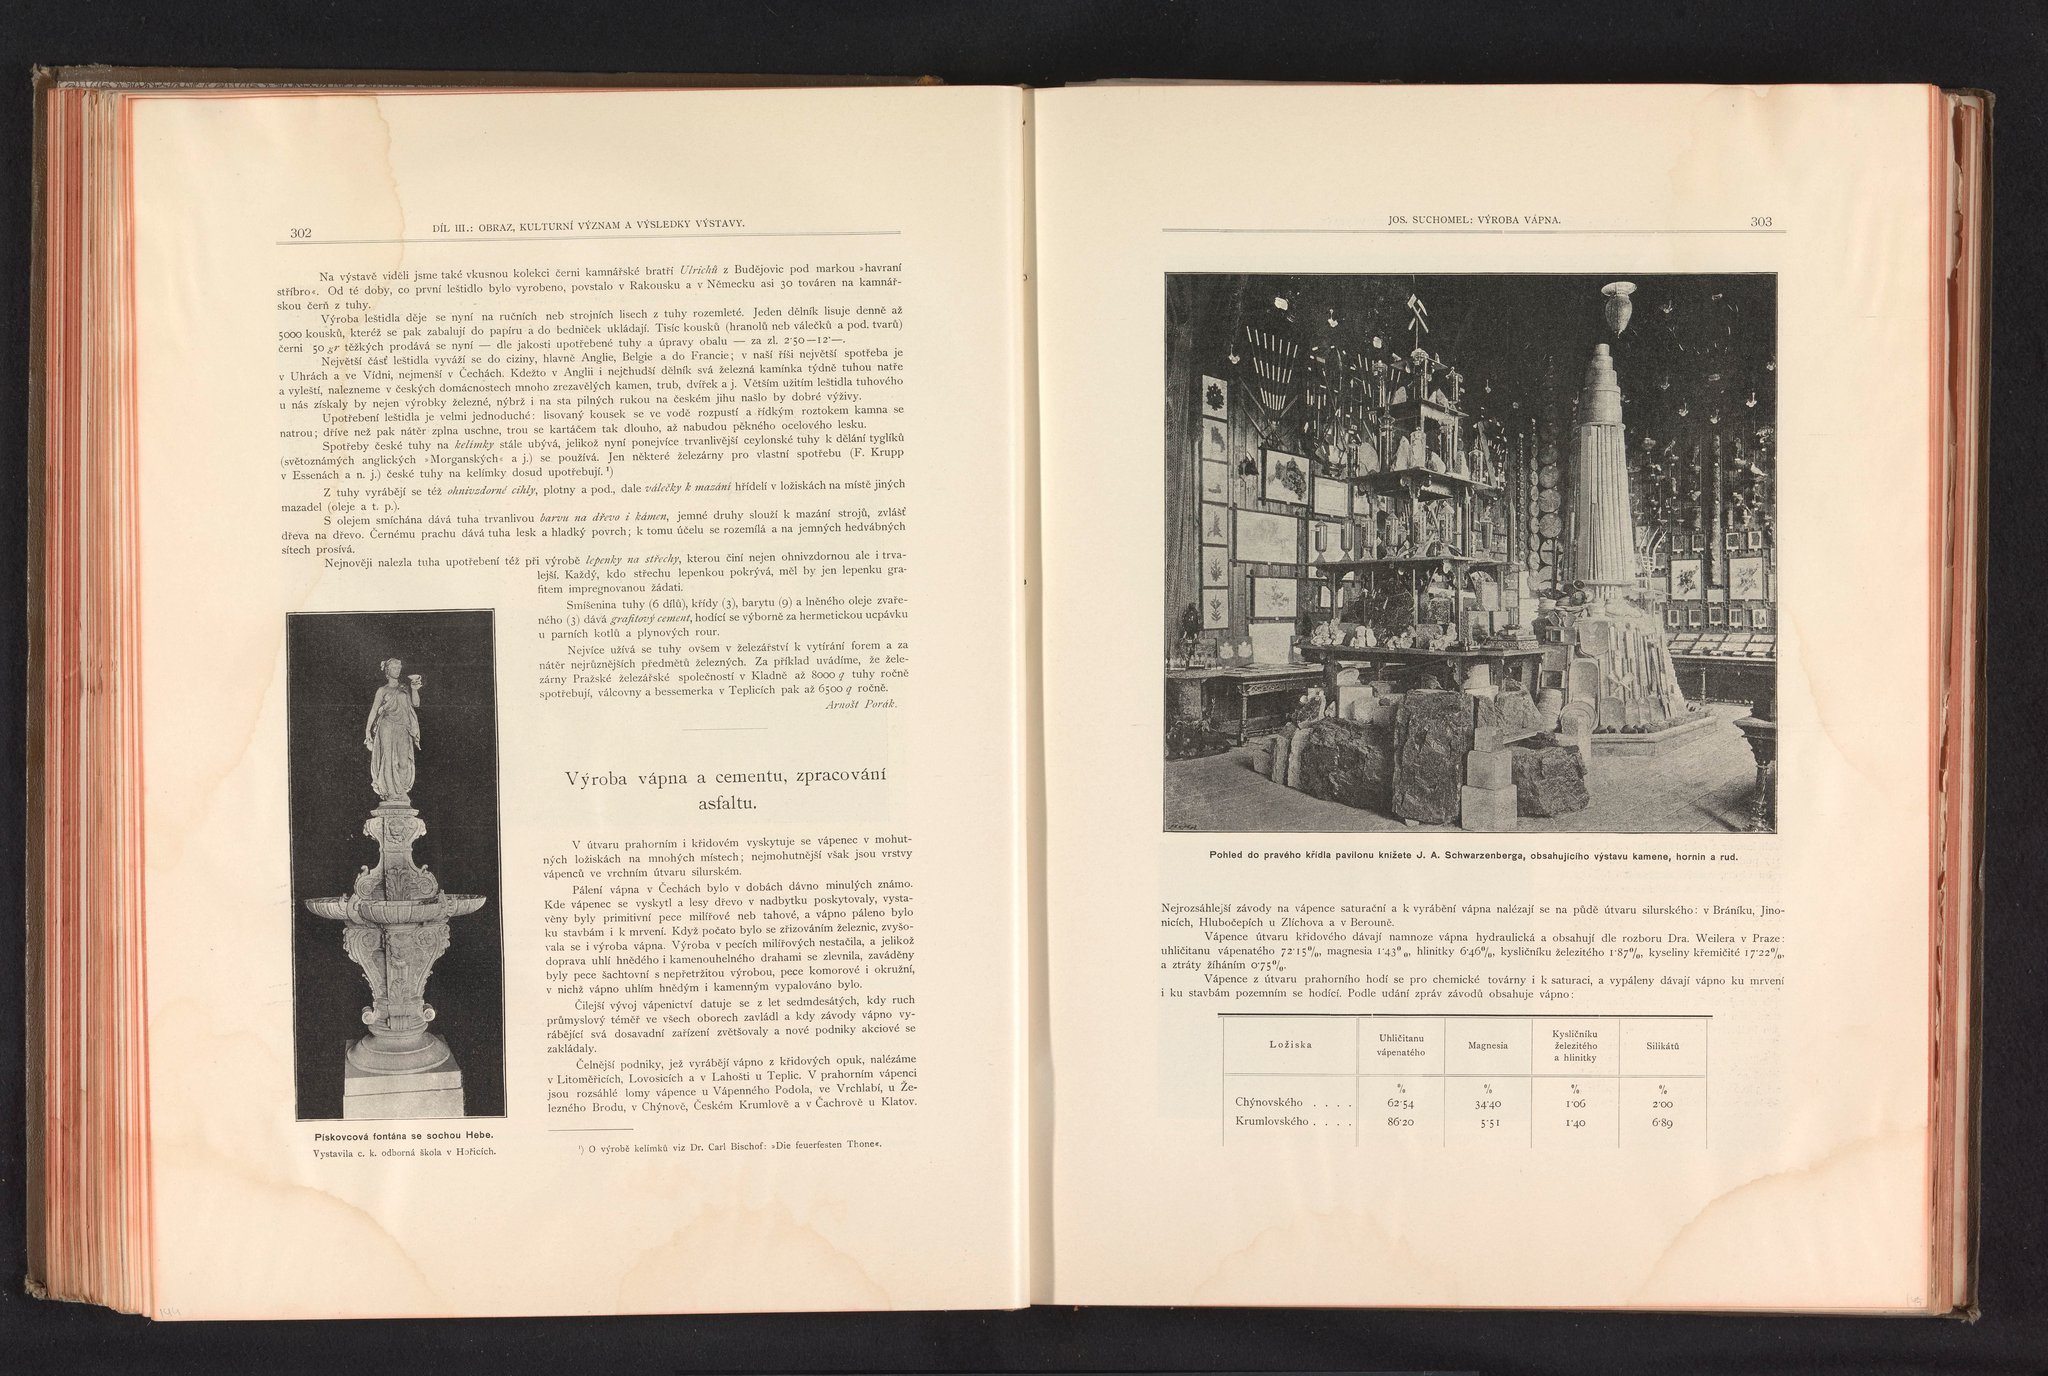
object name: page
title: Fontein met een standbeeld van Hebe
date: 1890-1895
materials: paper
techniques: autotype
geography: czech republic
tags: (story of) hebe (juventas), ornamental fountain, sculpture